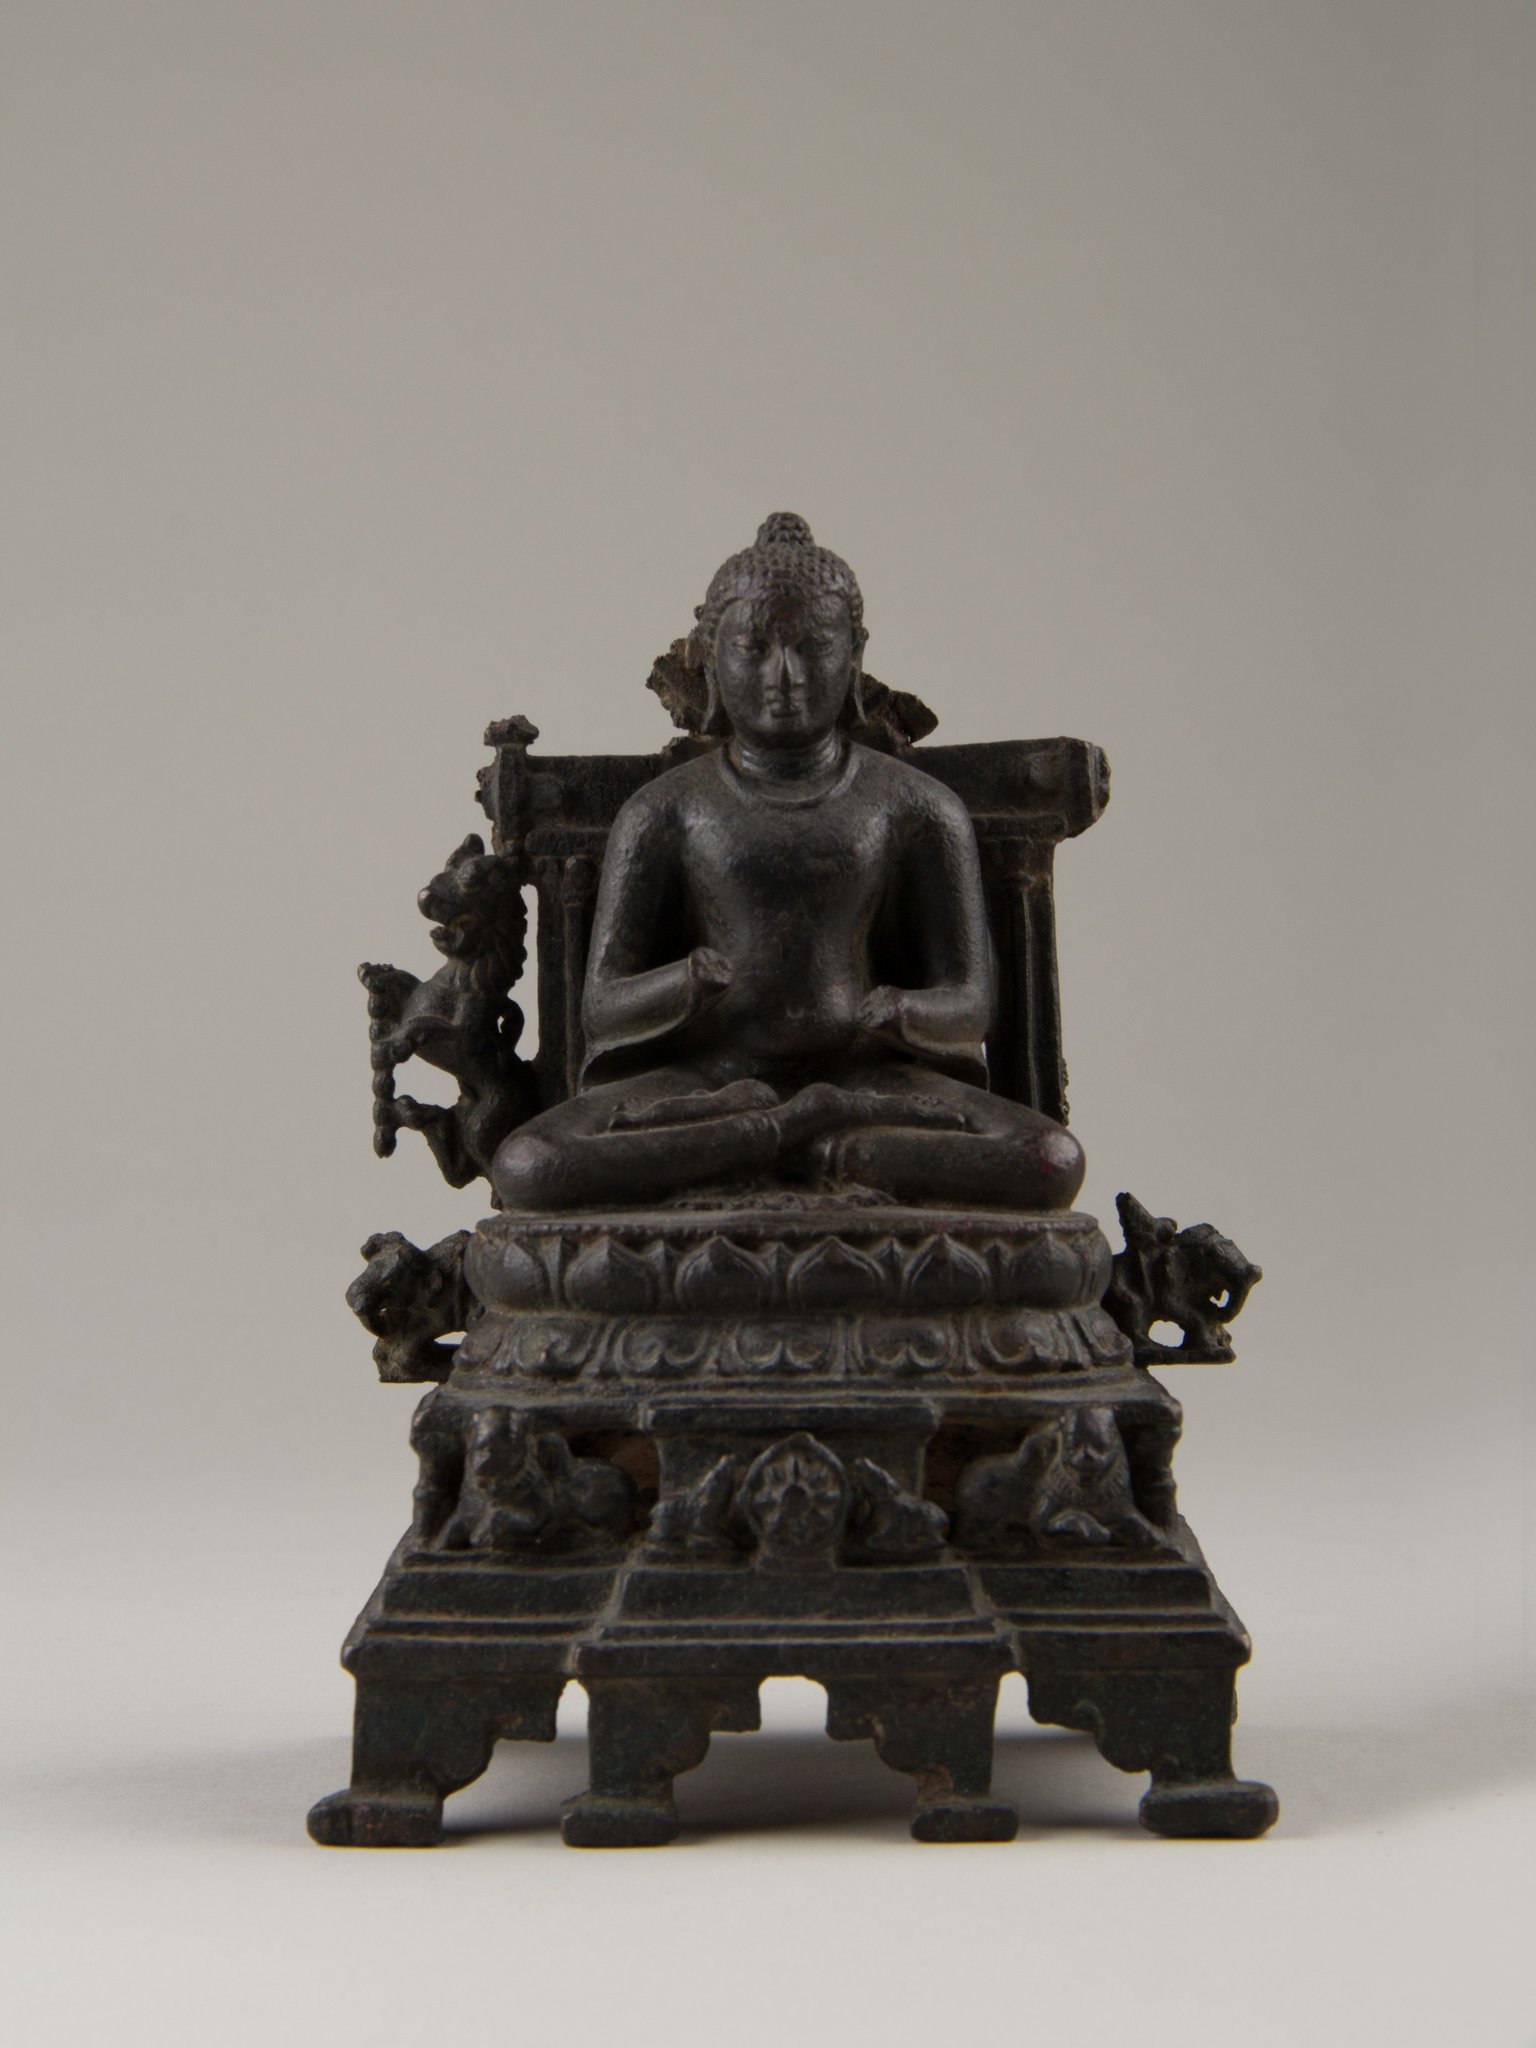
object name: shrine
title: Enthroned Preaching Buddha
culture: indian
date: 867-900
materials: bronze, silver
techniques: inlay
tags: buddhism,buddha